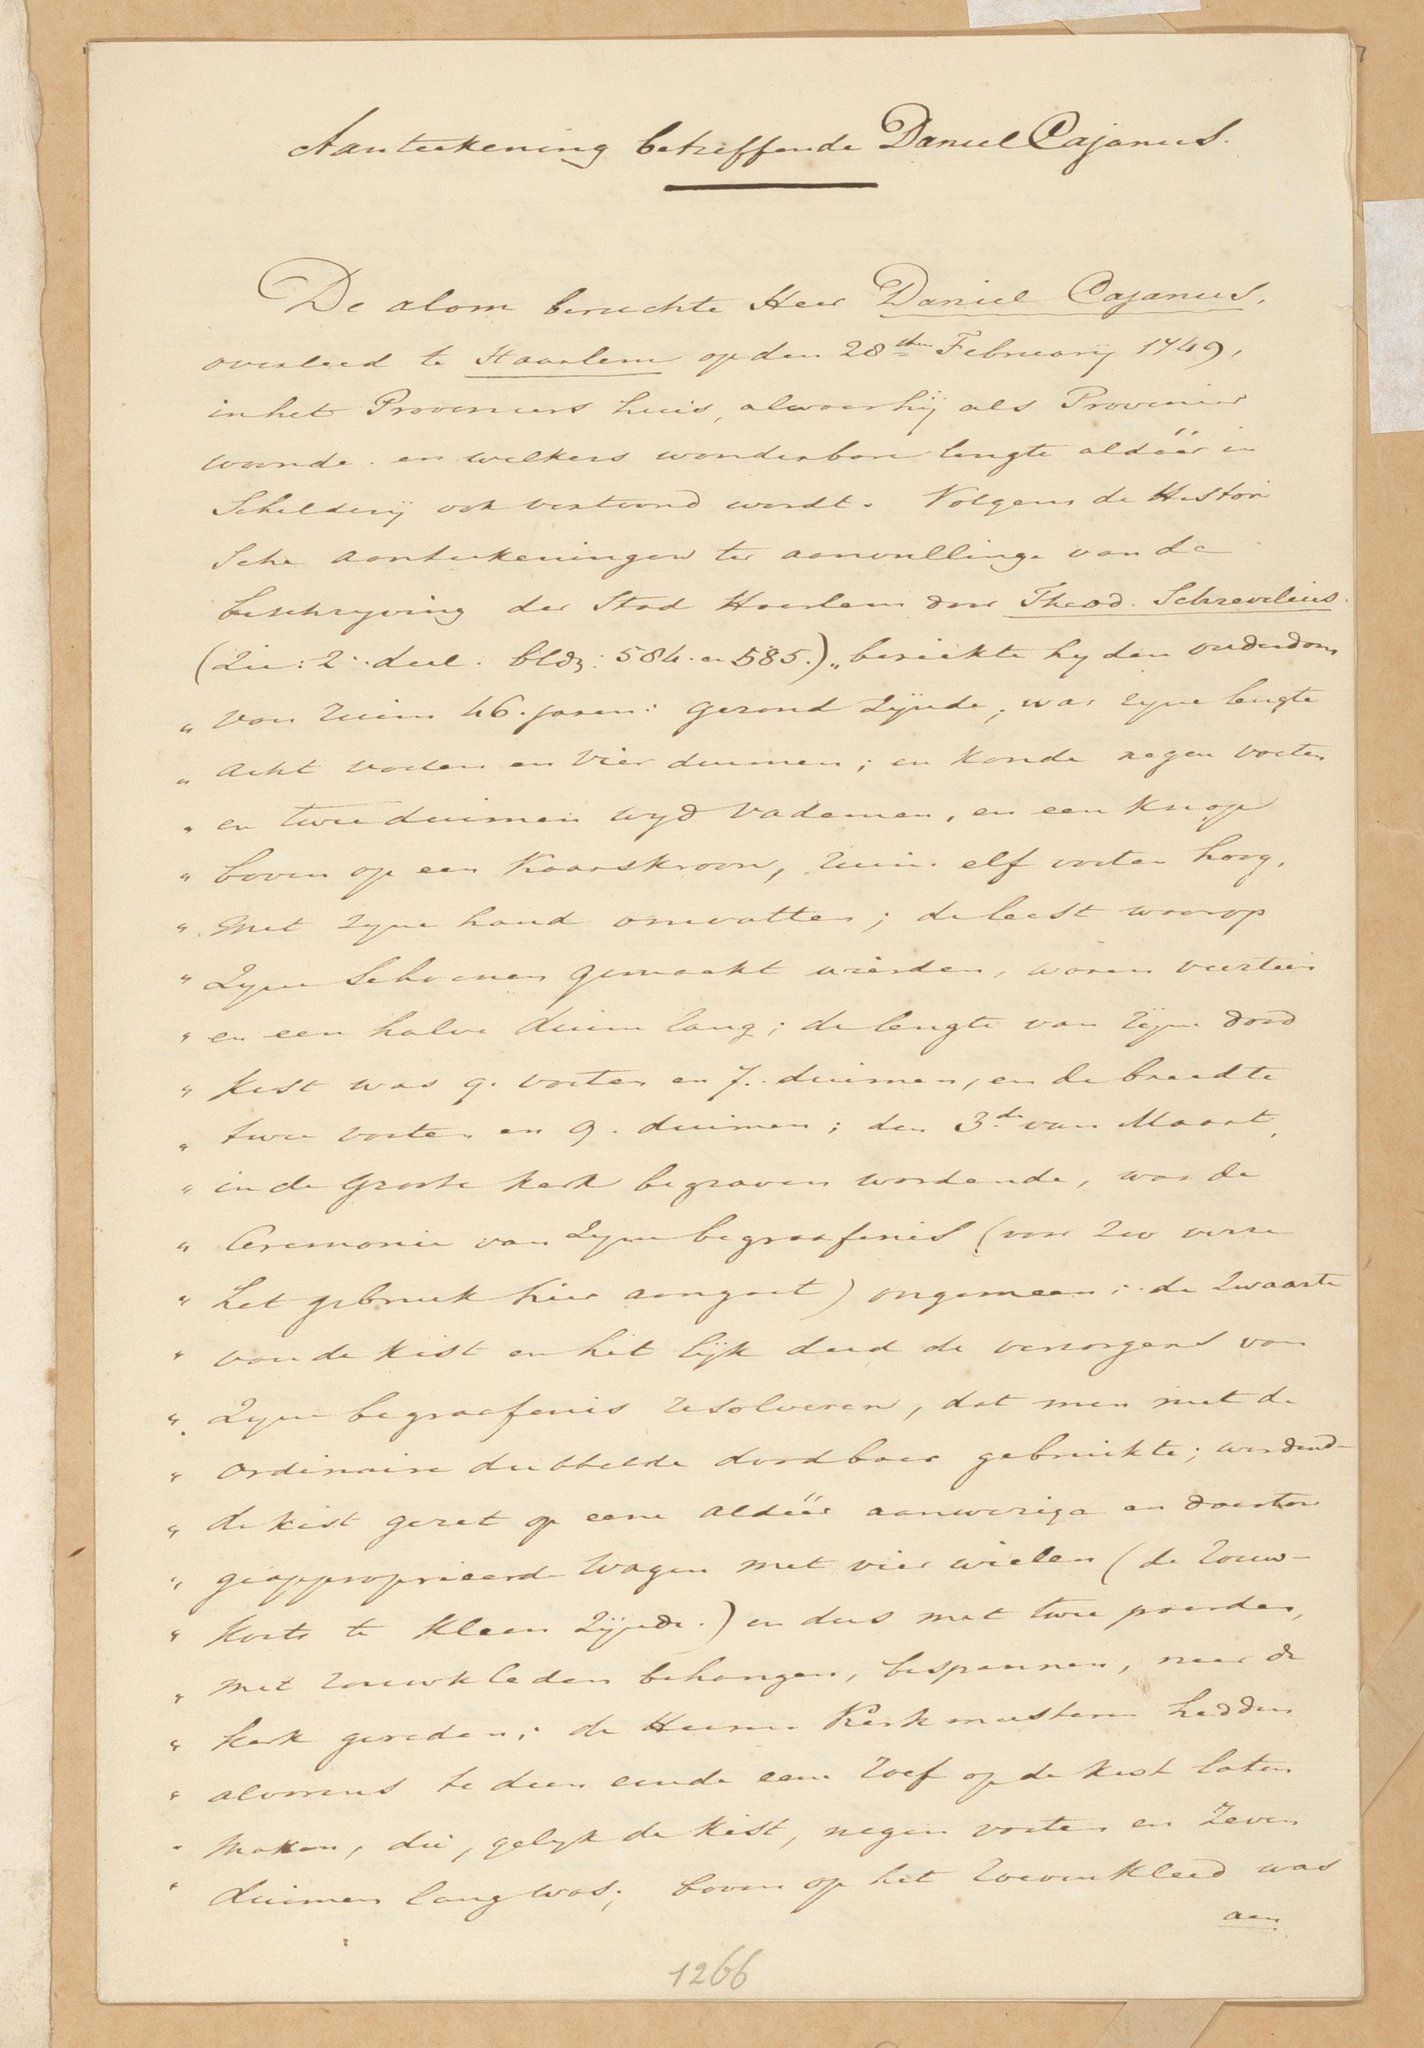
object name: text sheet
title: Levensbeschrijving van Daniel Cajanus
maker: Anonymous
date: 1749-1799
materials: ink, paper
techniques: pen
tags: historical persons (portraits and scenes from the life)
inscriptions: stamp, collector's mark: Lugt 1641, stamp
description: Onderwerpsrubrieken binnen de Atlas Zeden en Gewoonten: Zeden en Gewoonten in Engeren Zin. Volksleven. Volksfeesten. Kermistypen, wondermenschen en dergelijken.